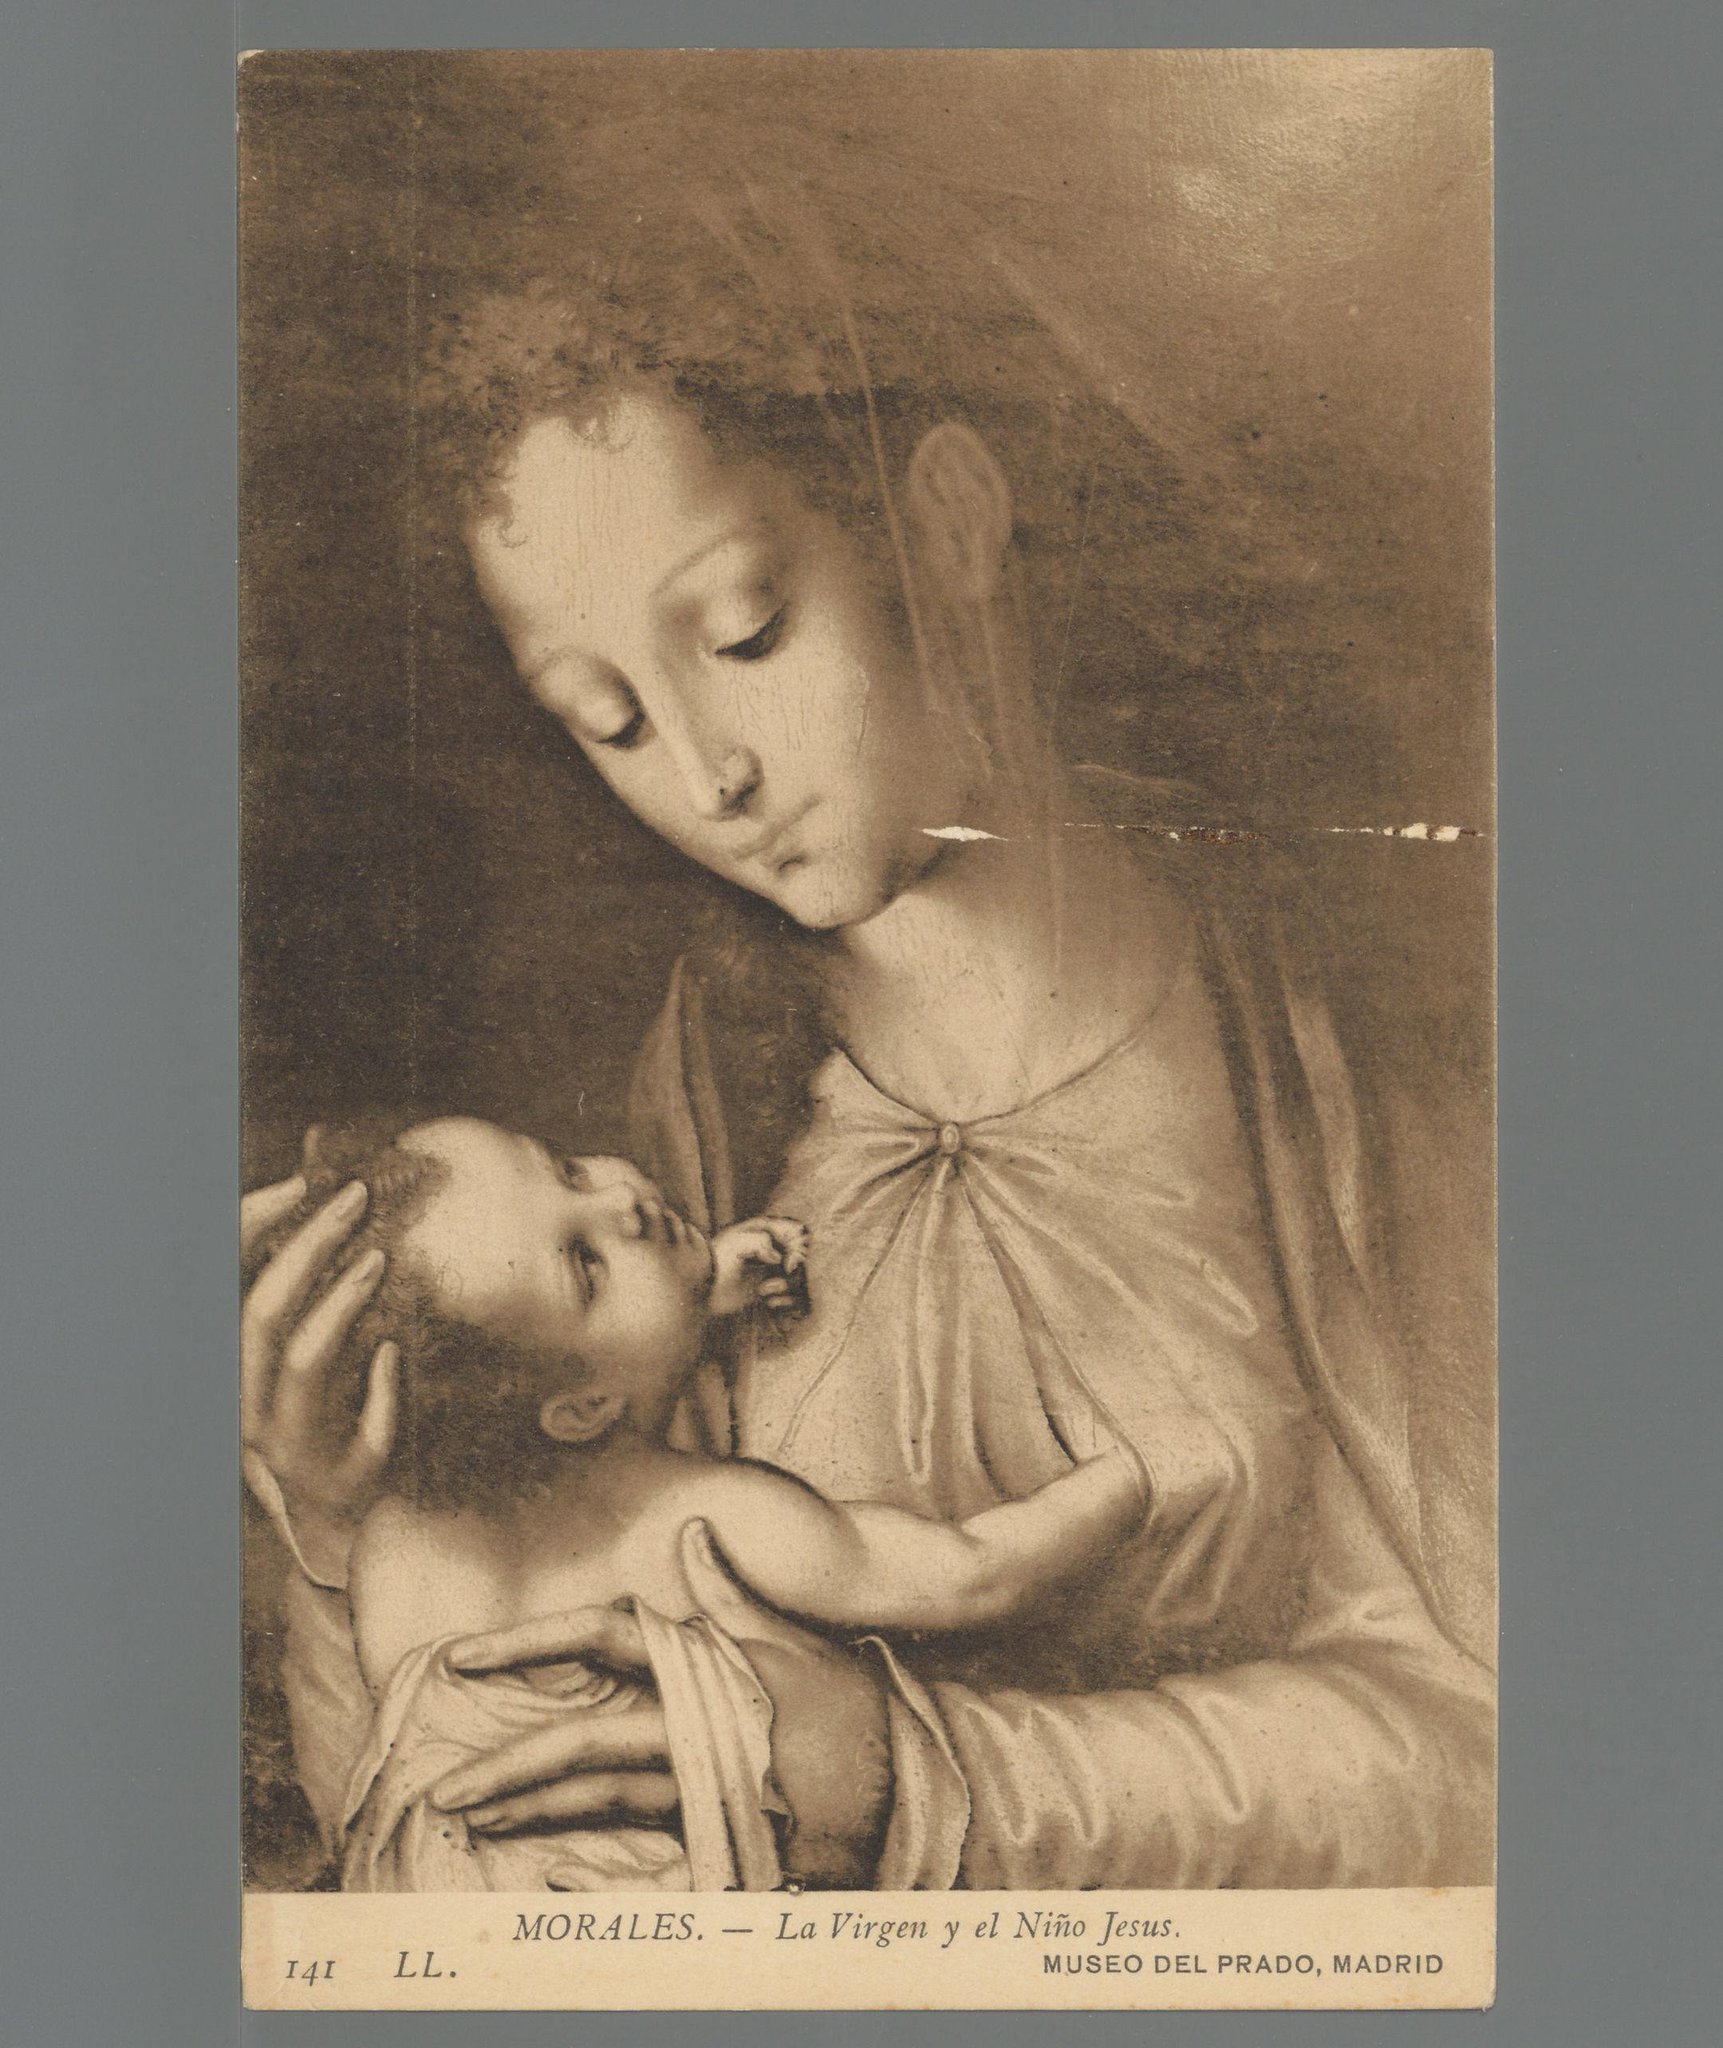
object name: photomechanical print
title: La Virgen y el Niño Jesus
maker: luis de morales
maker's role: painter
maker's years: 1500-1586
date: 1905-1920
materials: cardboard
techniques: photograph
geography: paris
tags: madonna: mary standing (or half-length), christ-child close to her bosom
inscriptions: collector's mark: ‘AFE v S’